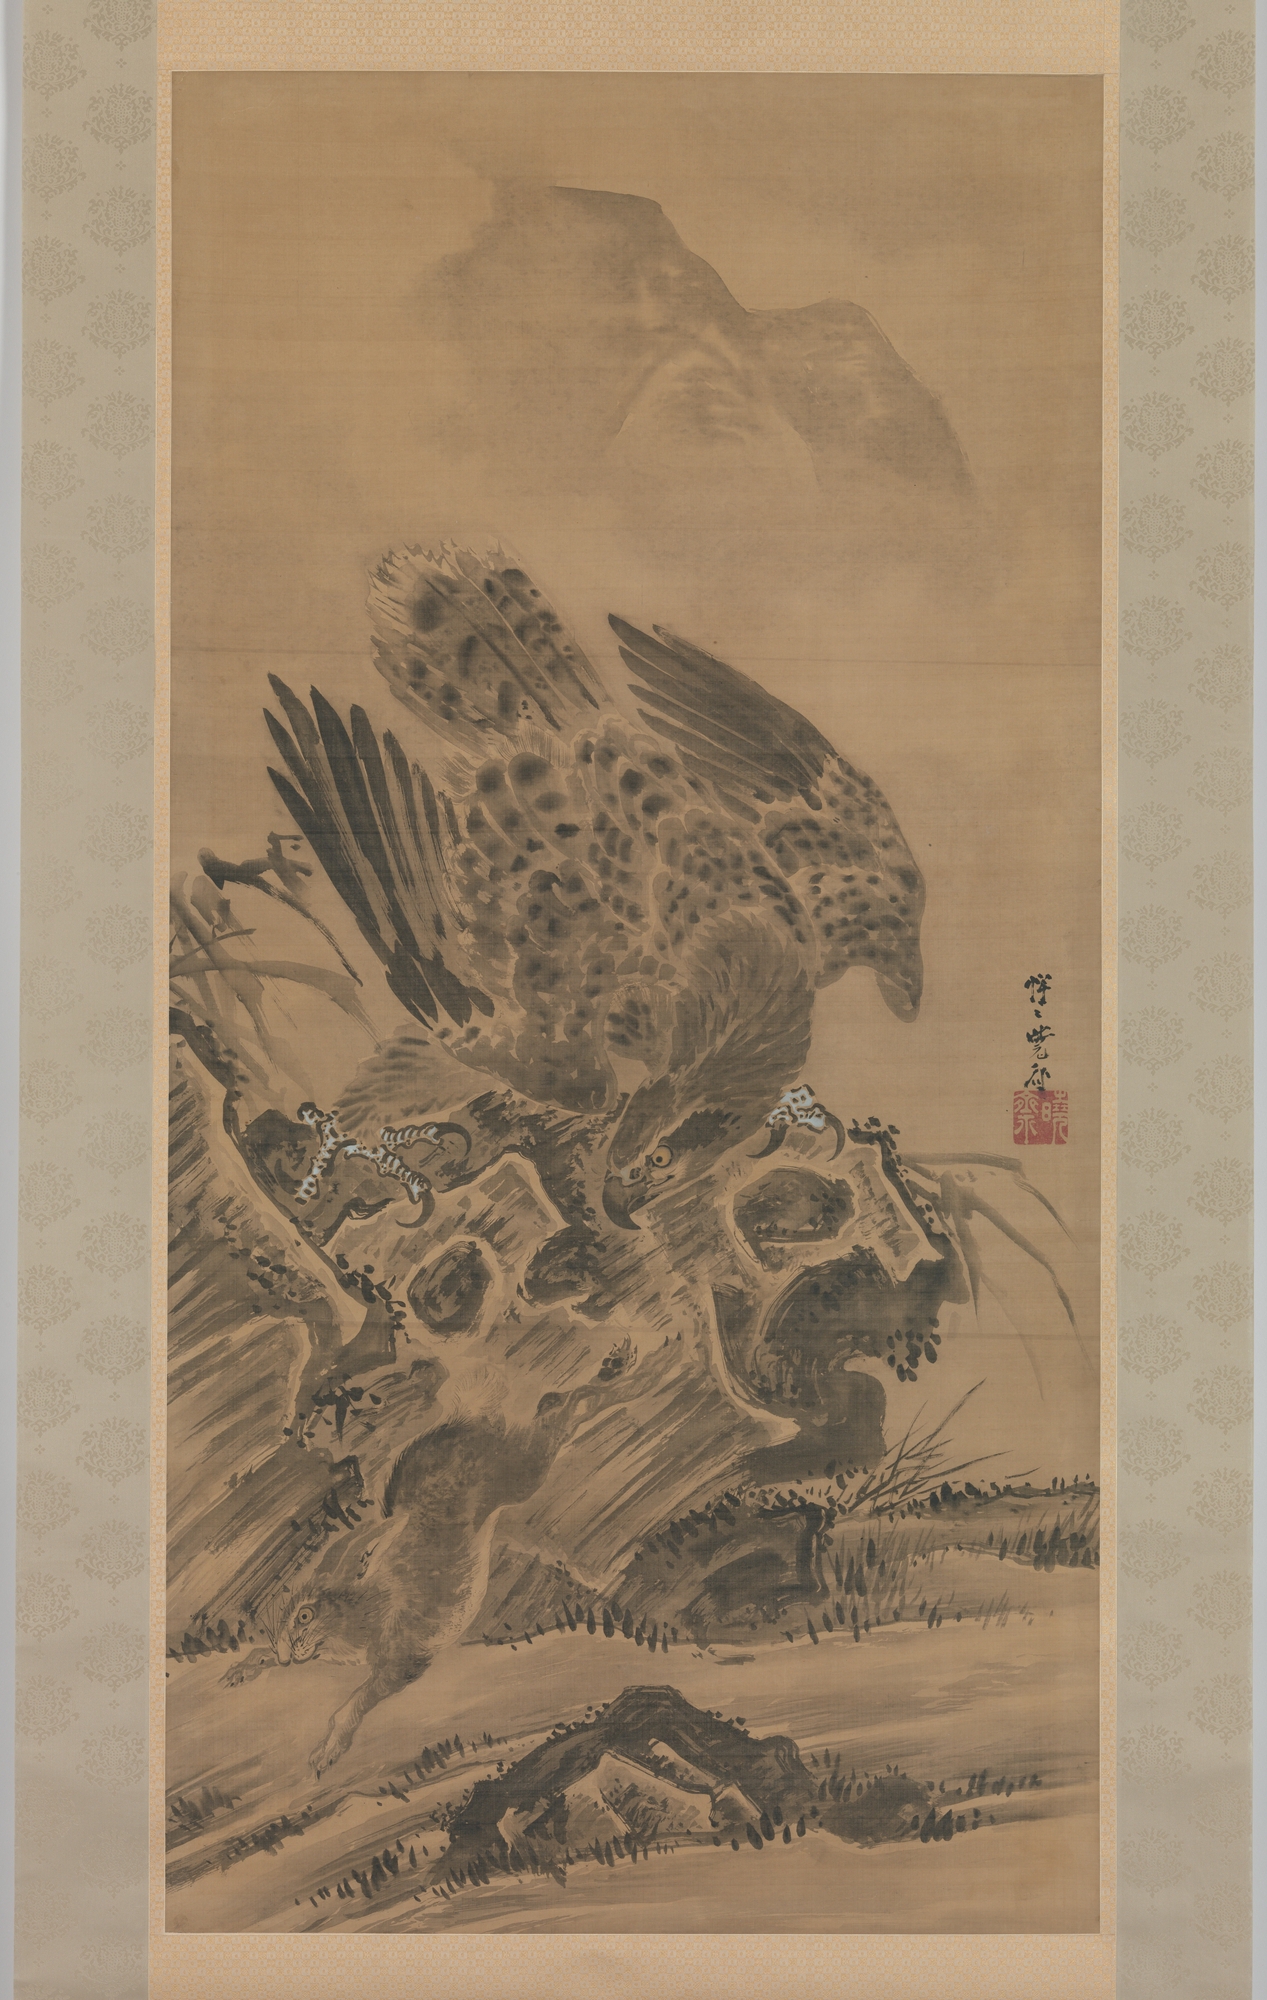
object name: hanging scroll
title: Eagle Pursuing Rabbit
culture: japanese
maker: kawanabe kyōsai 河鍋暁斎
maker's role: artist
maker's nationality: japanese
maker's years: 1831-1889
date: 1885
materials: ink, paper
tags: eagles,rabbits